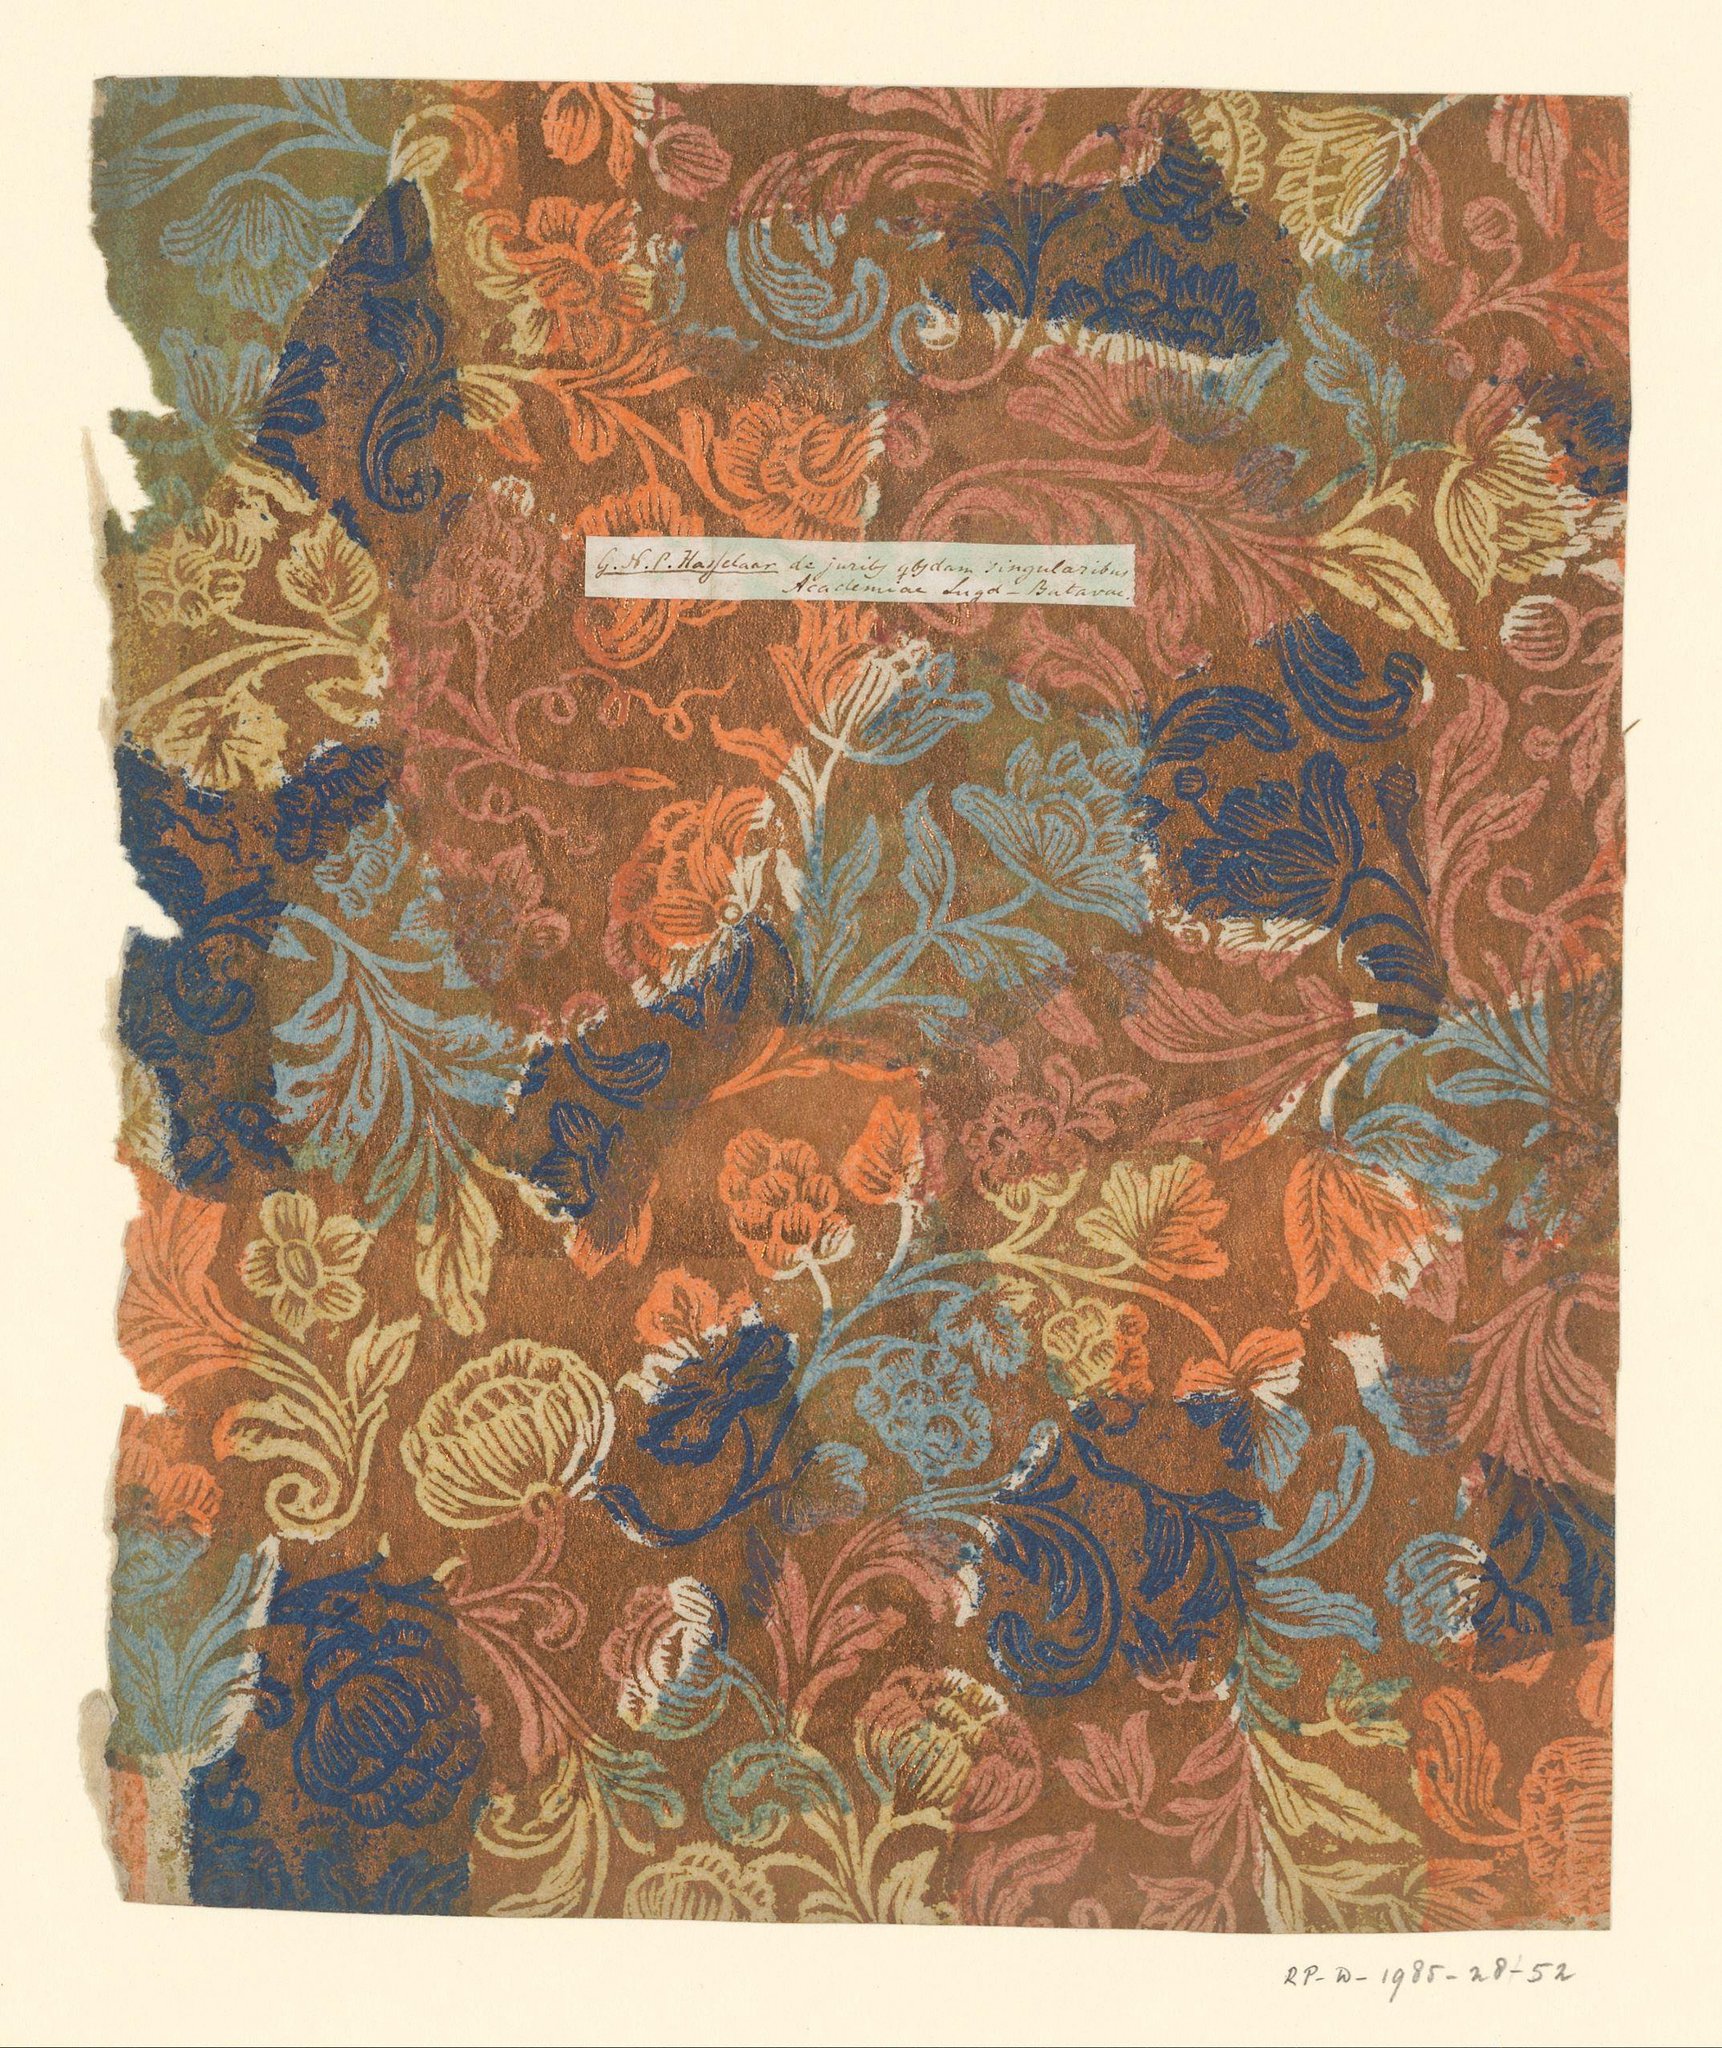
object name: brocade paper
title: Blad met bloemen en vruchten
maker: Anonymous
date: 1700-1850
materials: gold leaf, paper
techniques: relief print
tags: ornament derived from plant forms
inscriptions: collector's mark: Lugt 2760, collector's mark: Lugt 2228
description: Blad met bloemen en vruchten. Met etiket met opschrift: 'G.H.P. Hasselaar ... Batavae'. Helft van een omslag.